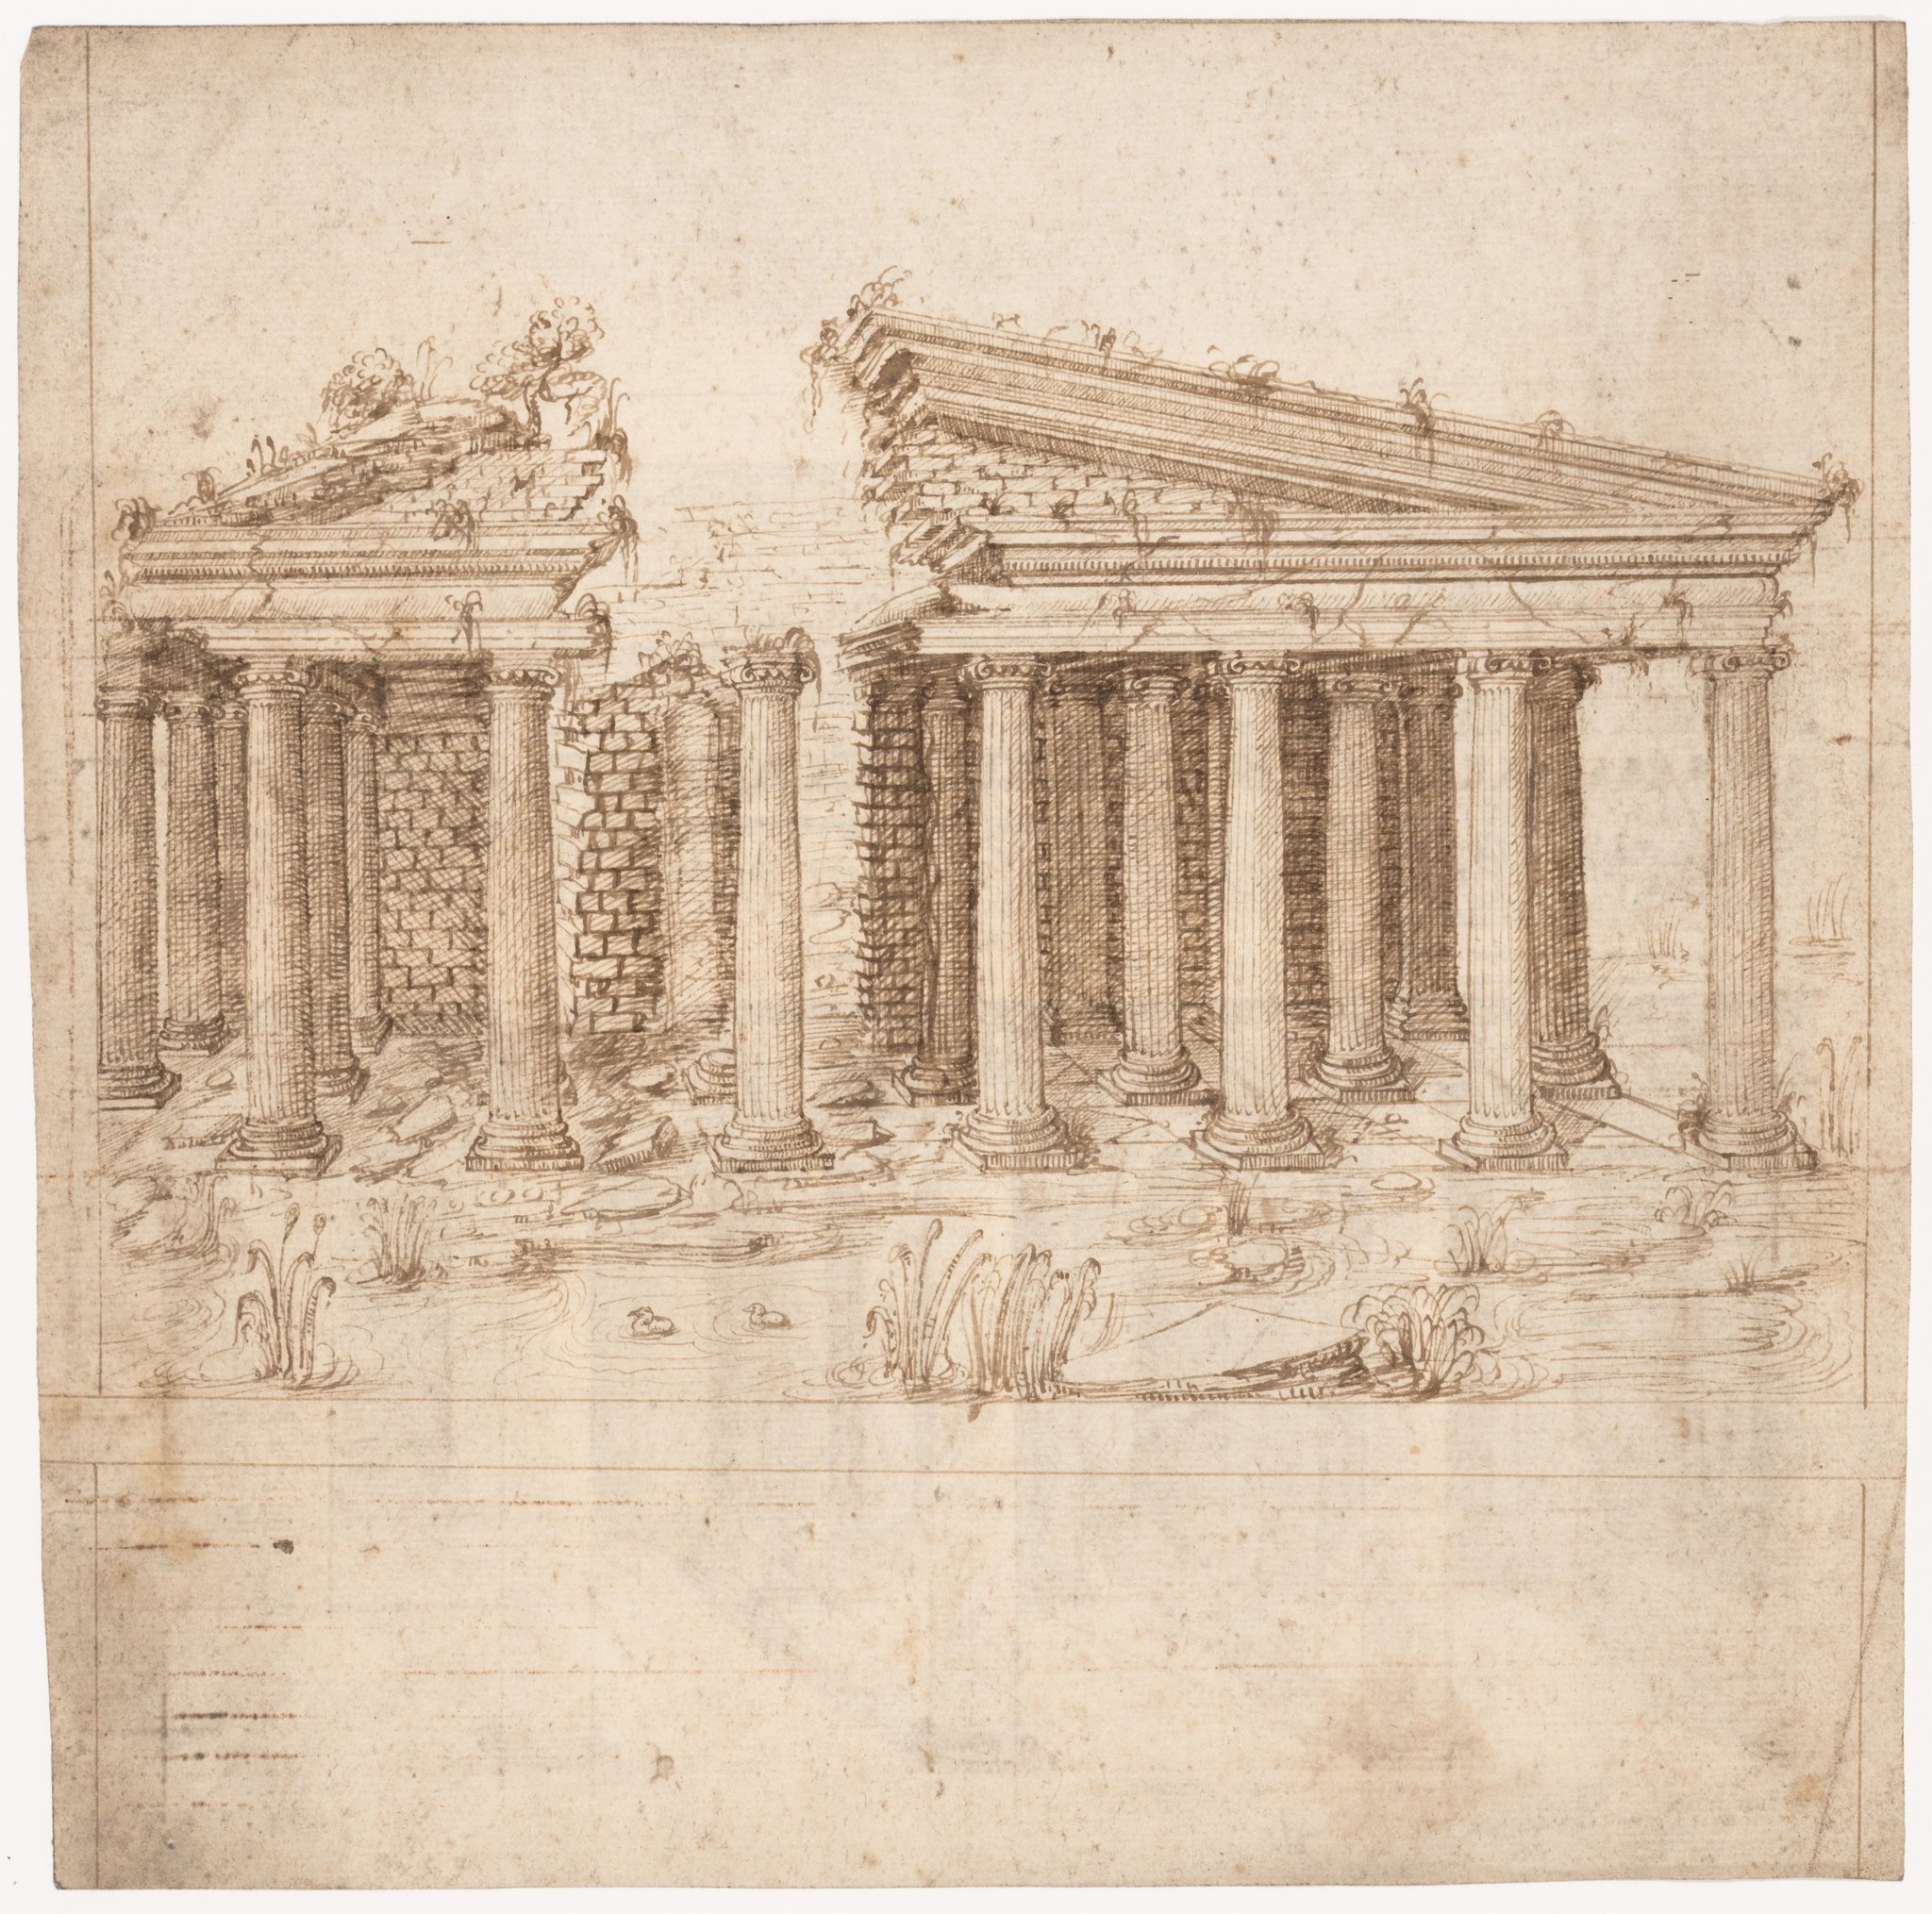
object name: drawing ornament architecture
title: Recto: Front Elevation of a Roman Temple in Ruins (inspired by Giuliano da Sangallo); Verso: Elevation of the Nave of a Roman Basilica in Ruins (? the Basilica Giulia, inspired by Giuliano da Sangallo).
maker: sangallo family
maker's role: artist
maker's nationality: italian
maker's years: 1530-1545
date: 1530-1545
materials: ink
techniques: pen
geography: france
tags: architecture,temples,ruins